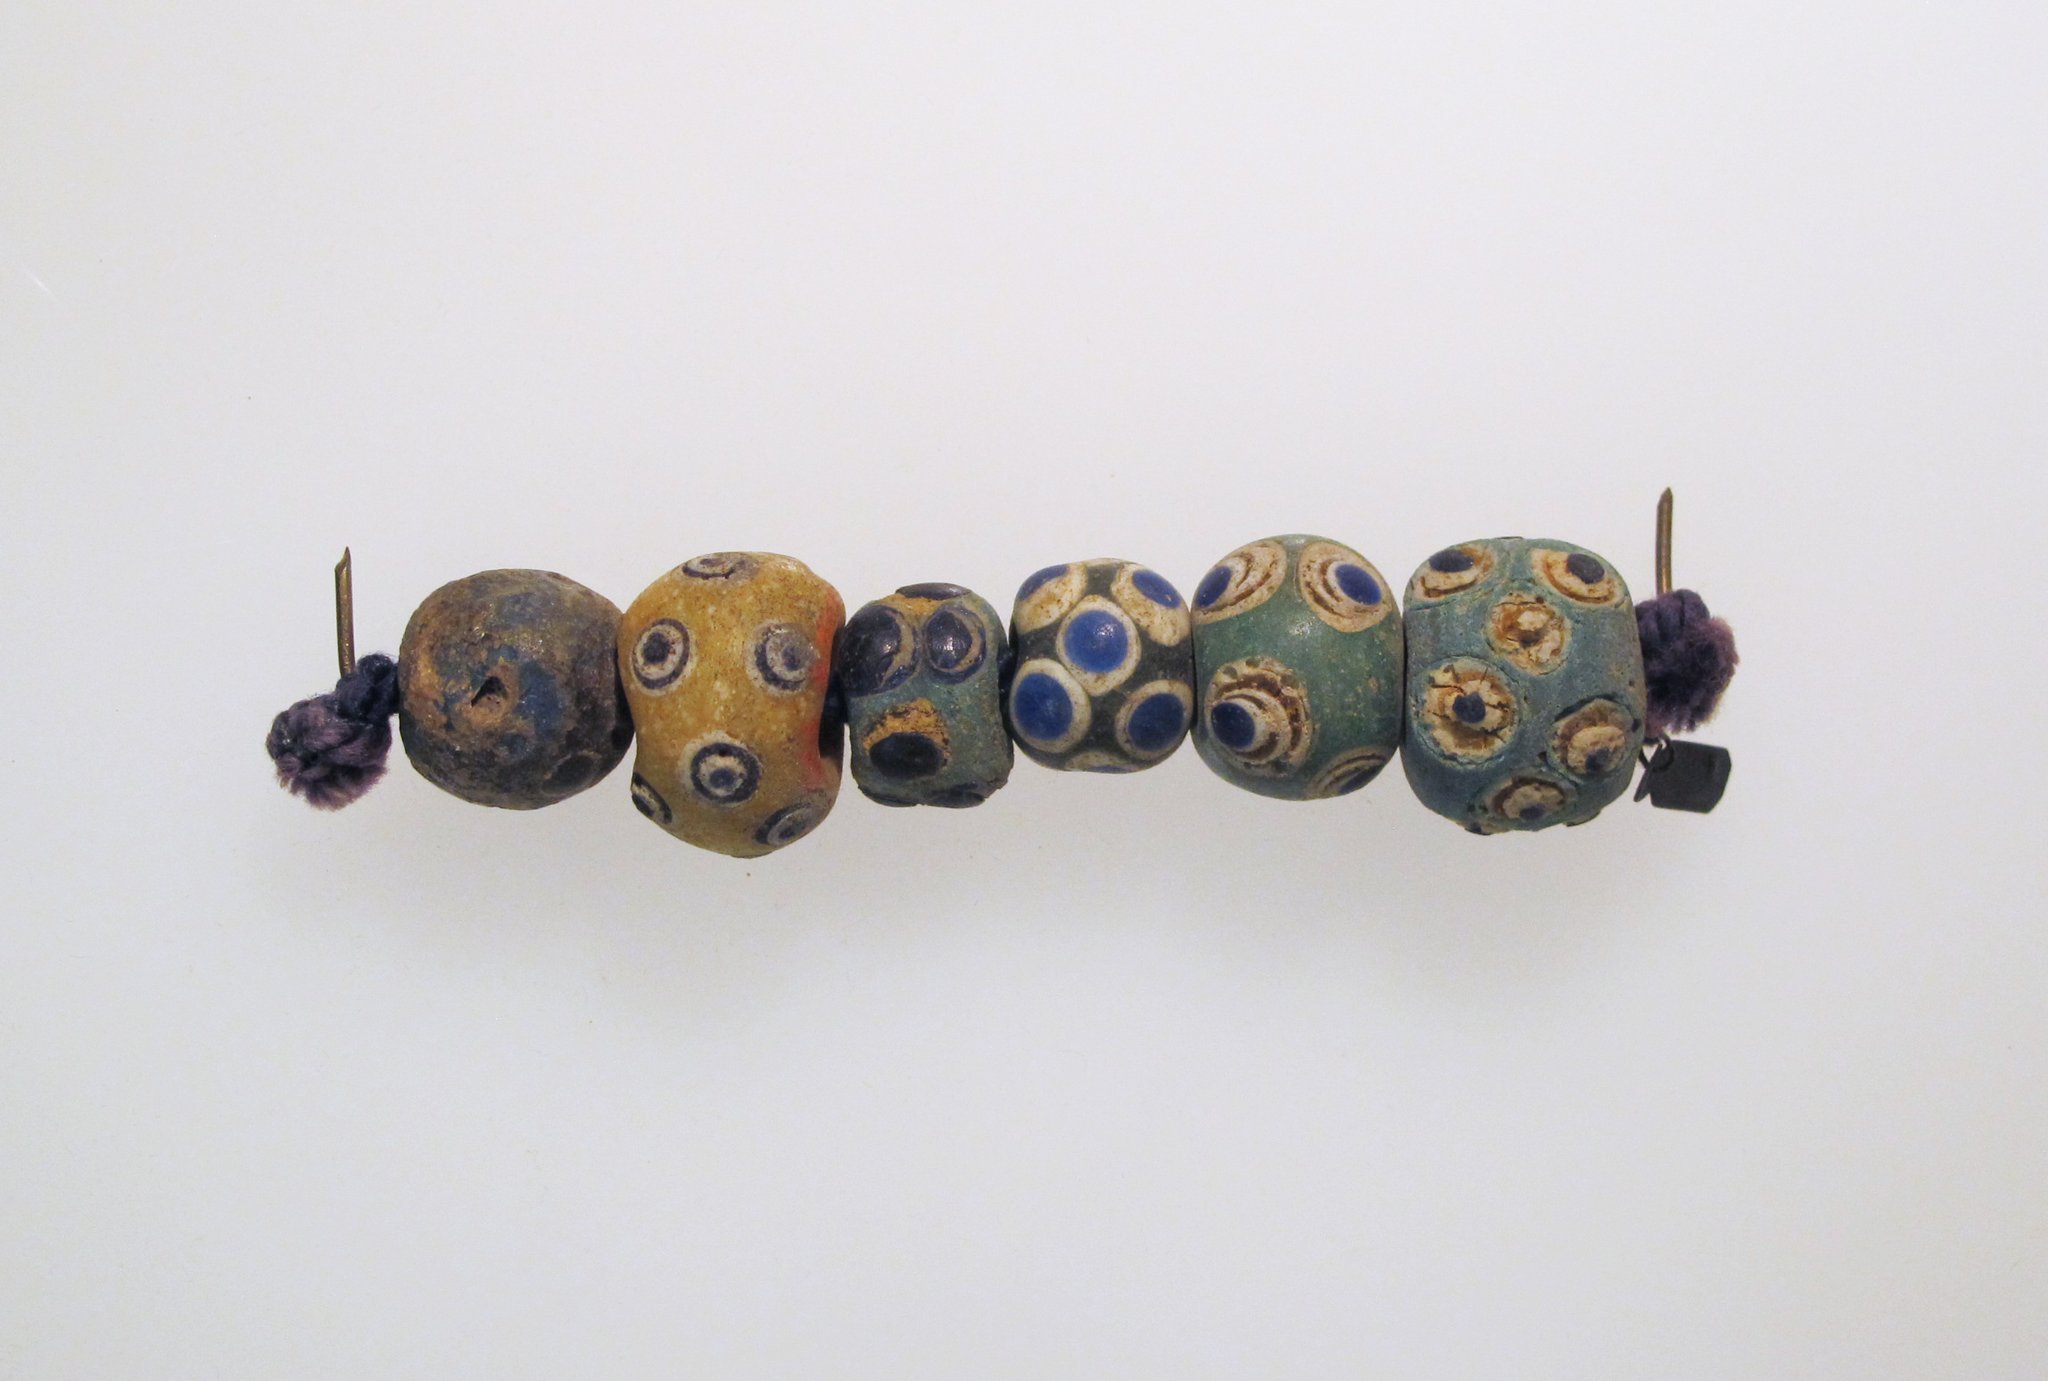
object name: bead, 6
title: Beads, 6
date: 7000 BCE-330 CE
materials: glass